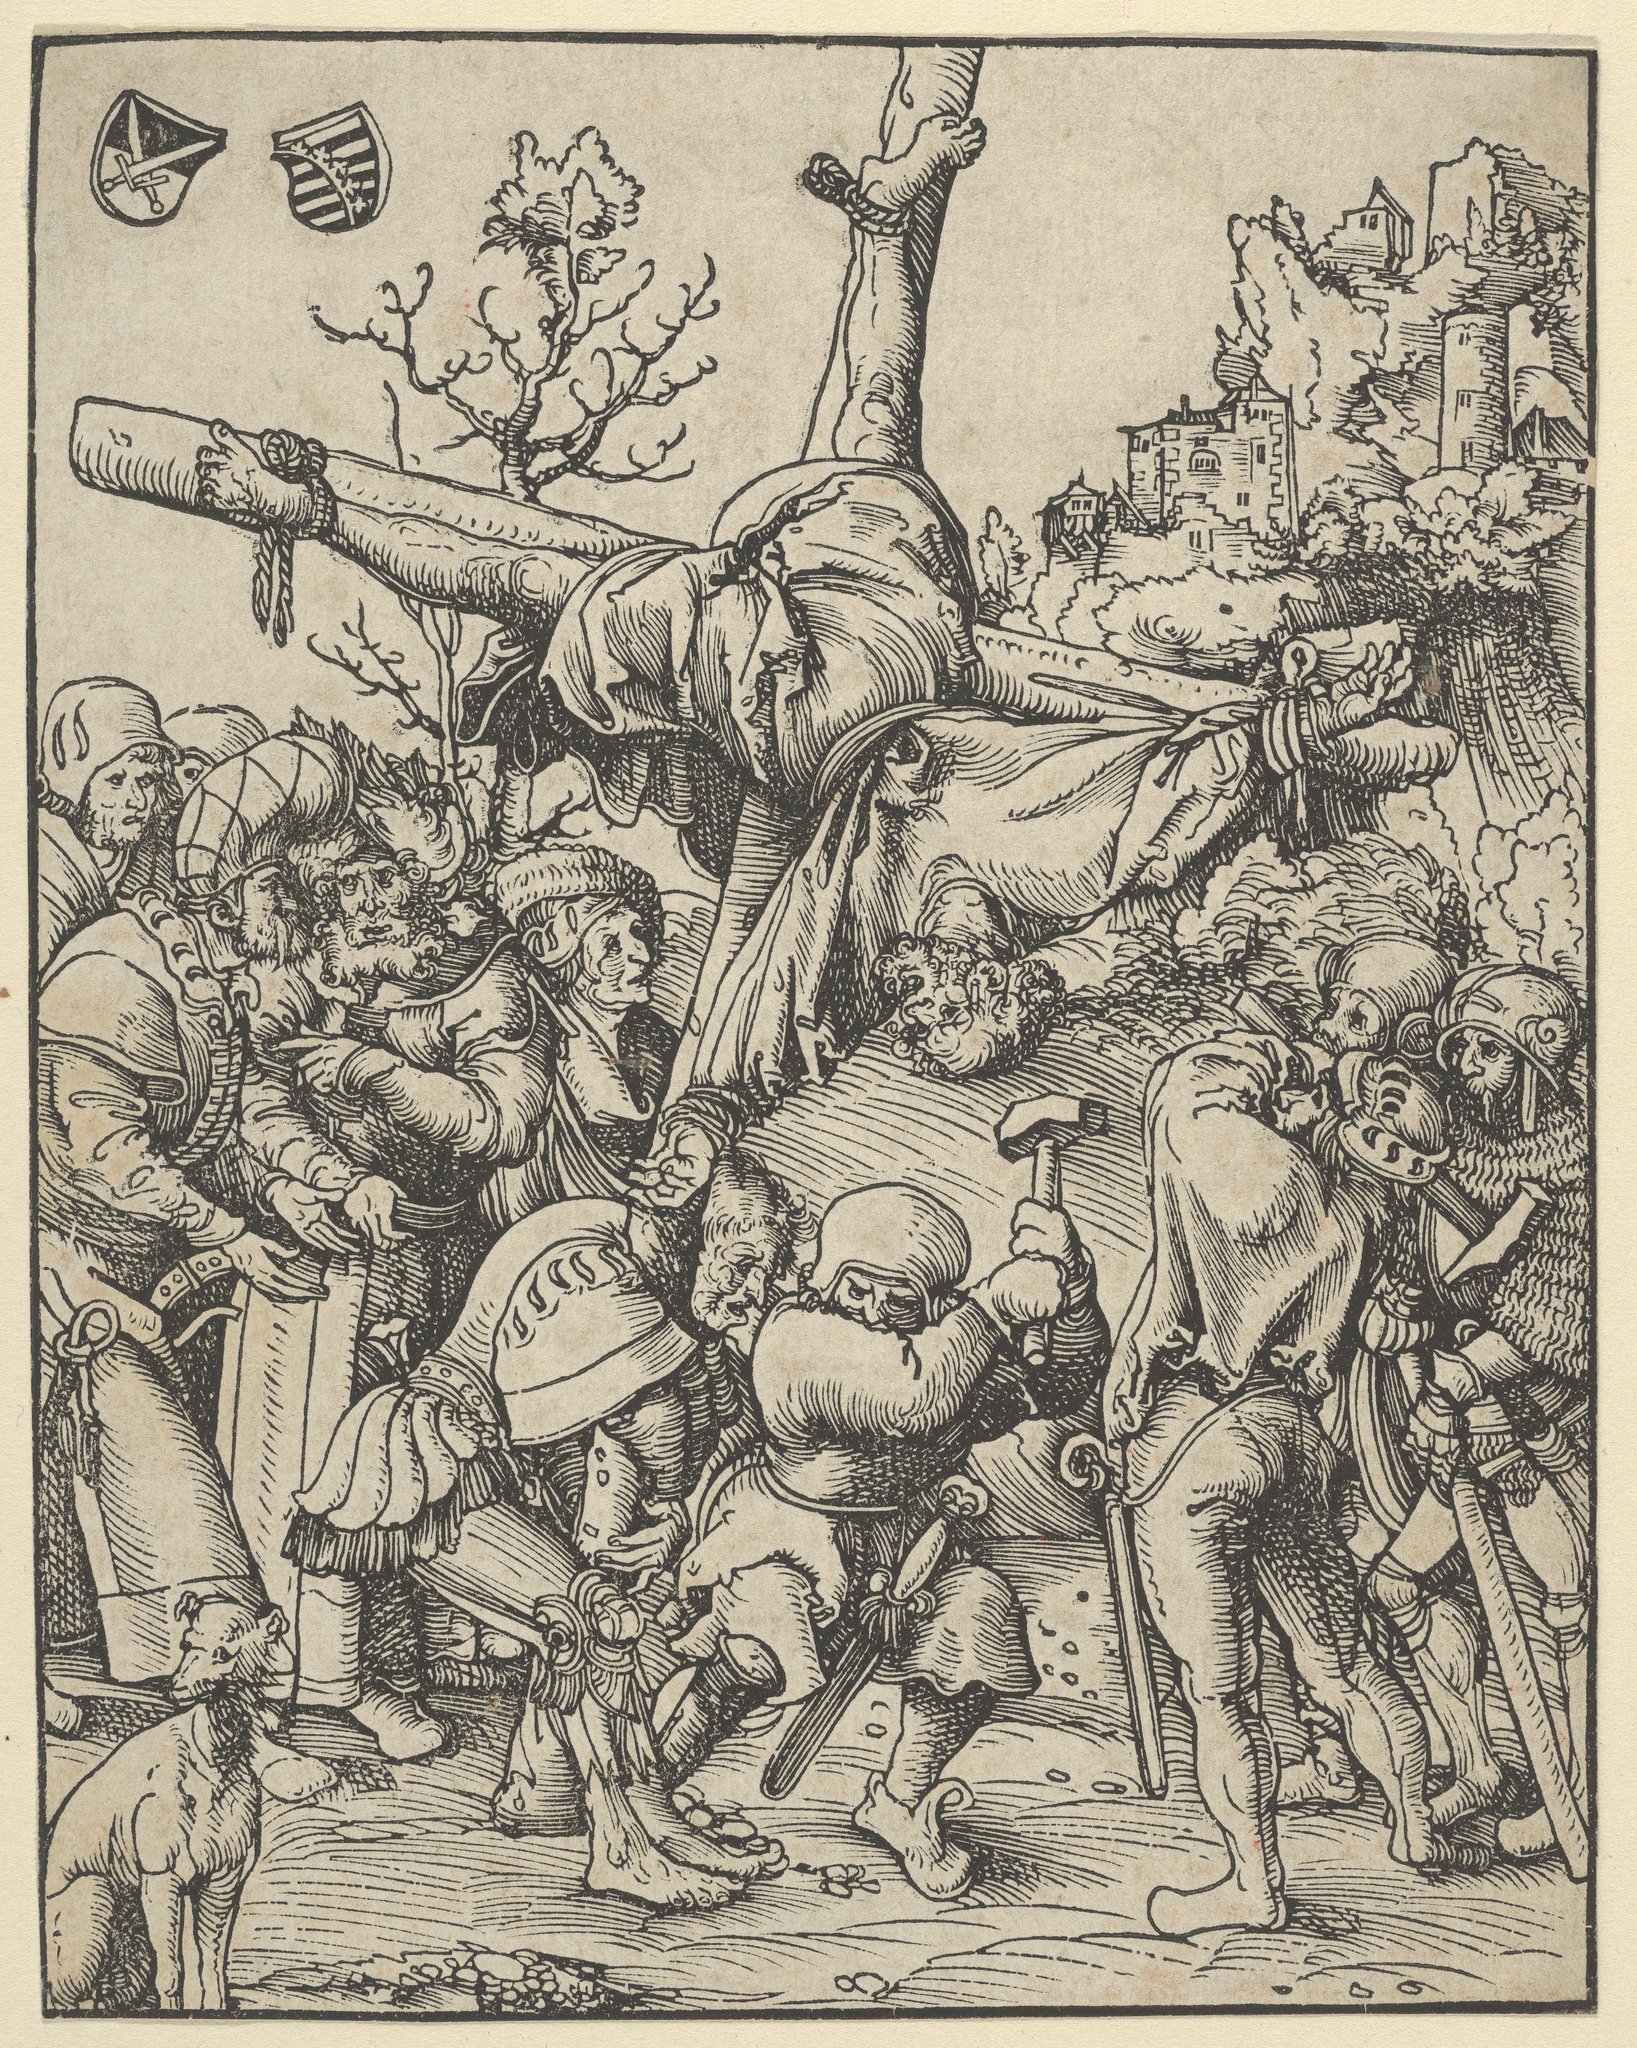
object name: print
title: Peter from the Martyrdom of the Twelve Apostles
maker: lucas cranach the elder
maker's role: artist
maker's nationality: german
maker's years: 1472-1553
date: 1472-1553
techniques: woodcut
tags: suffering,men,apostles,saint peter